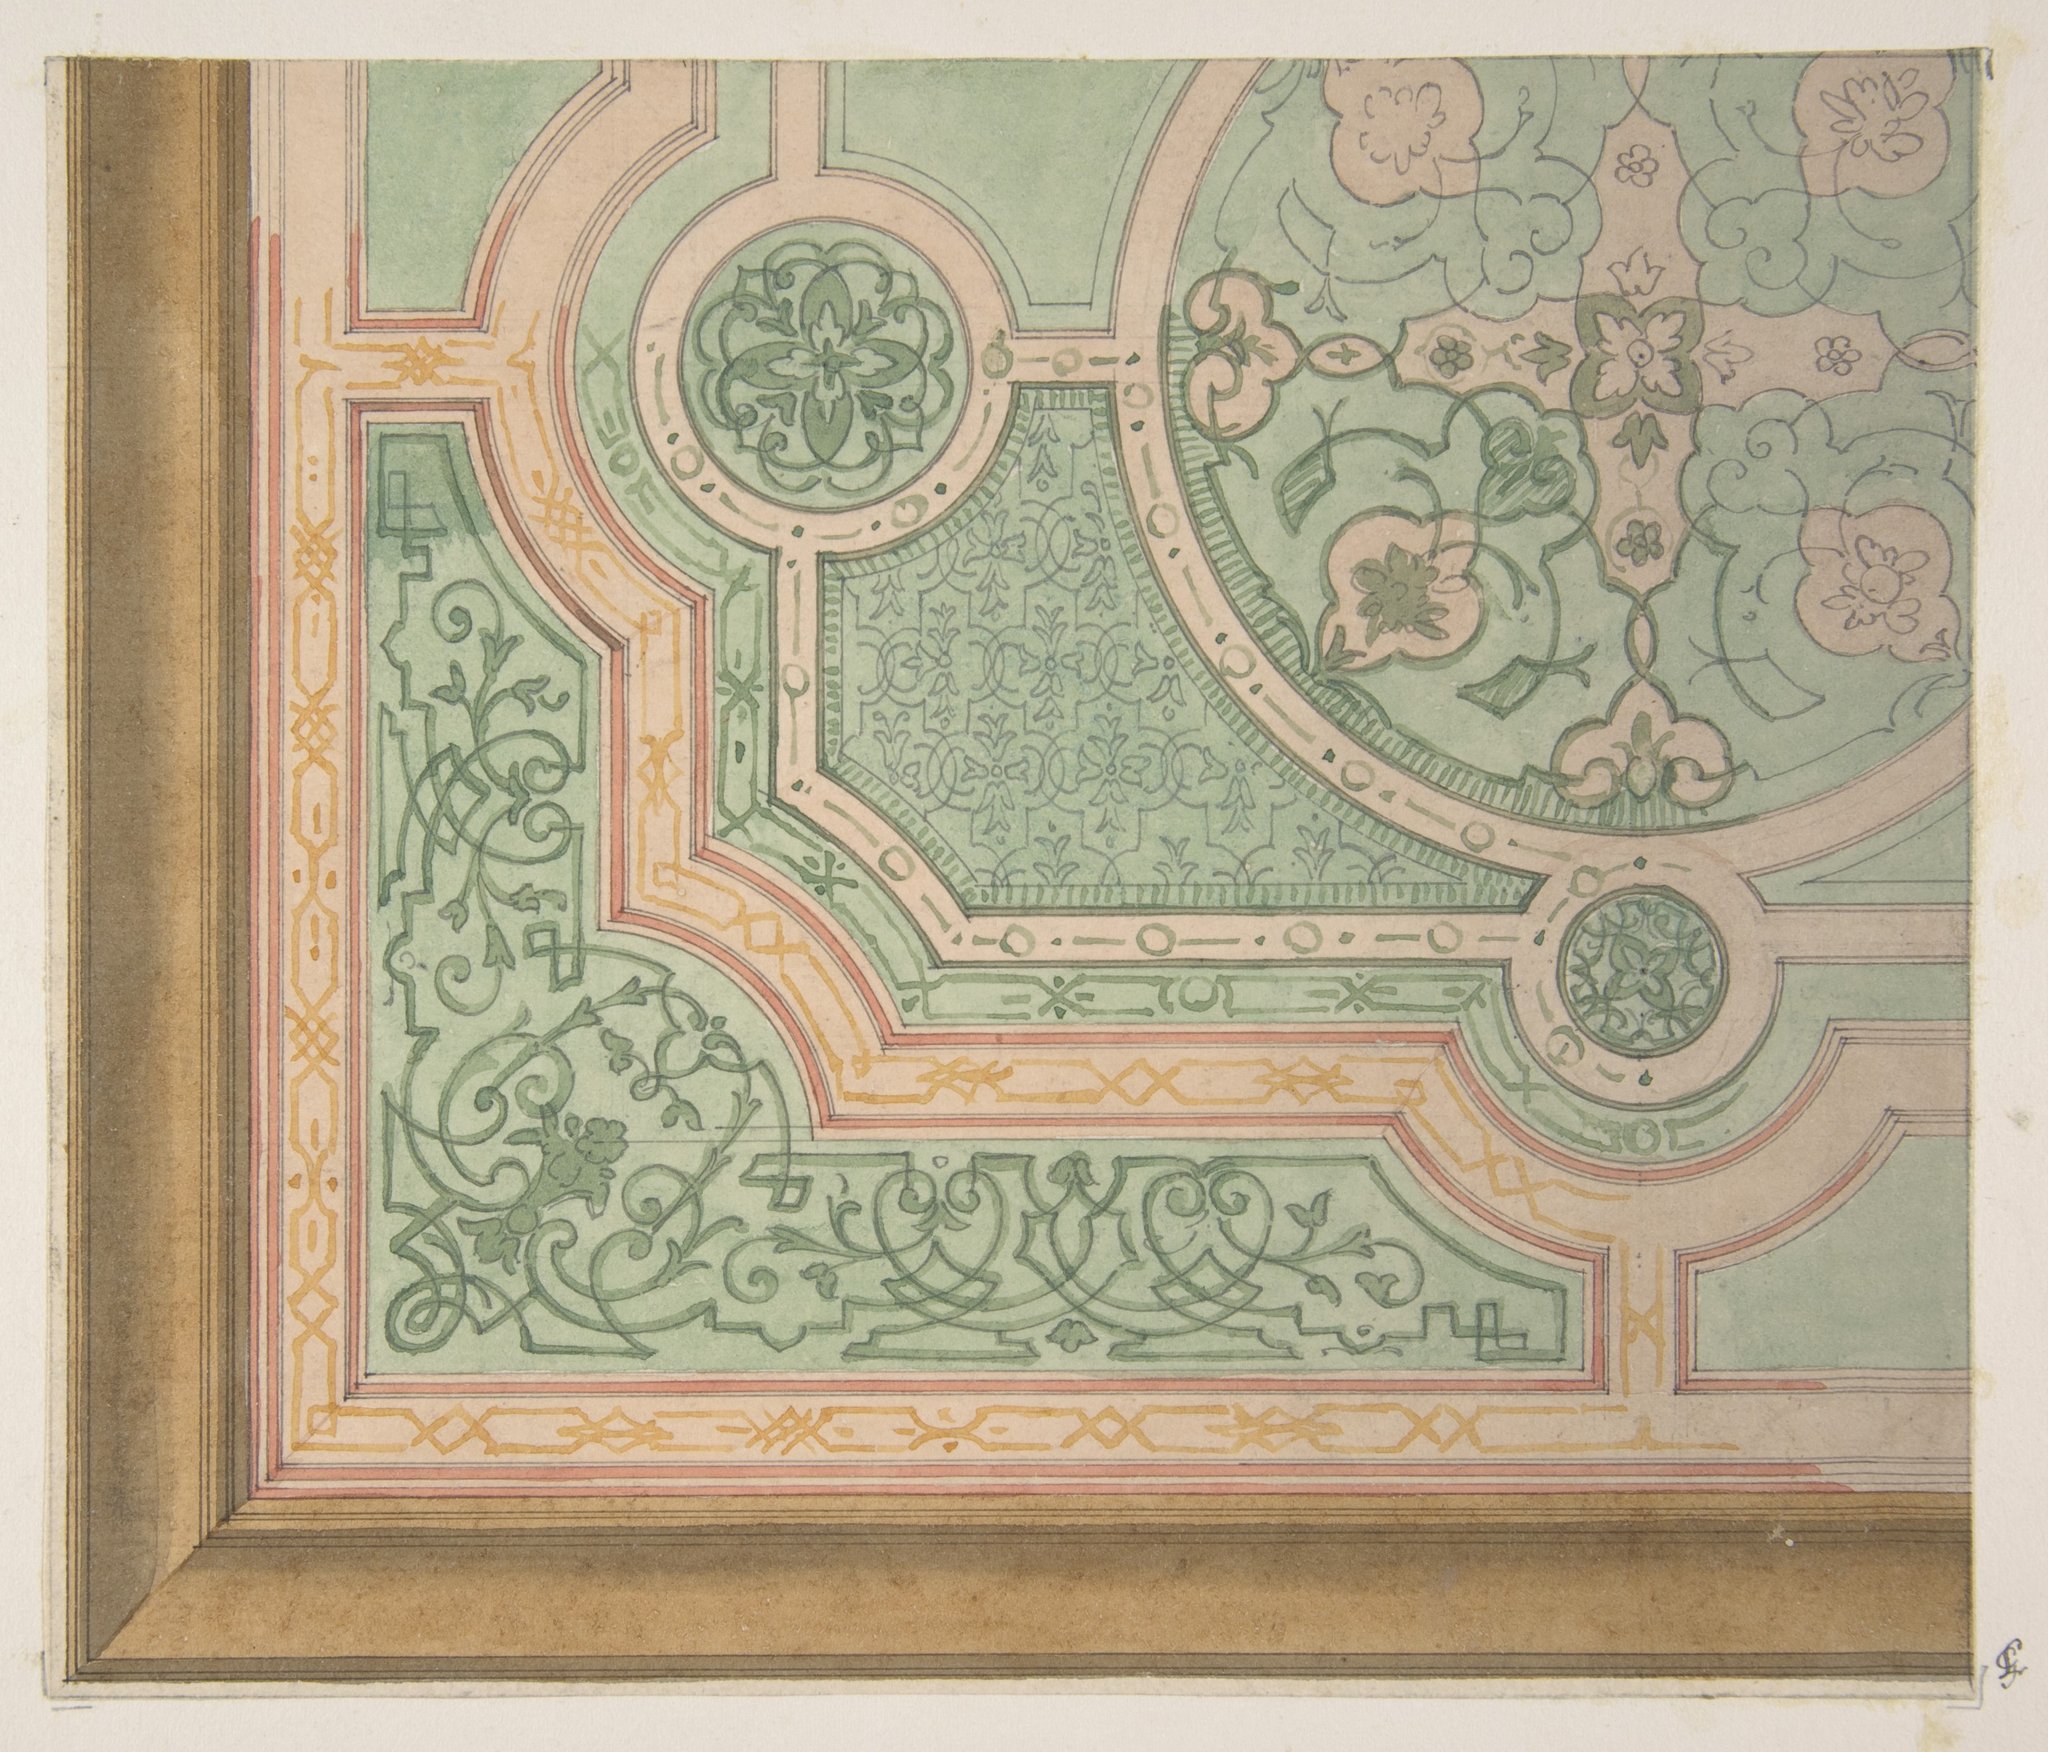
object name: drawing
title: Design for the decoration of a ceiling with circular medallions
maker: jules-edmond-charles lachaise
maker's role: artist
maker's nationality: french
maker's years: 1897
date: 1830-1897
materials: graphite, paper, watercolor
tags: ceilings